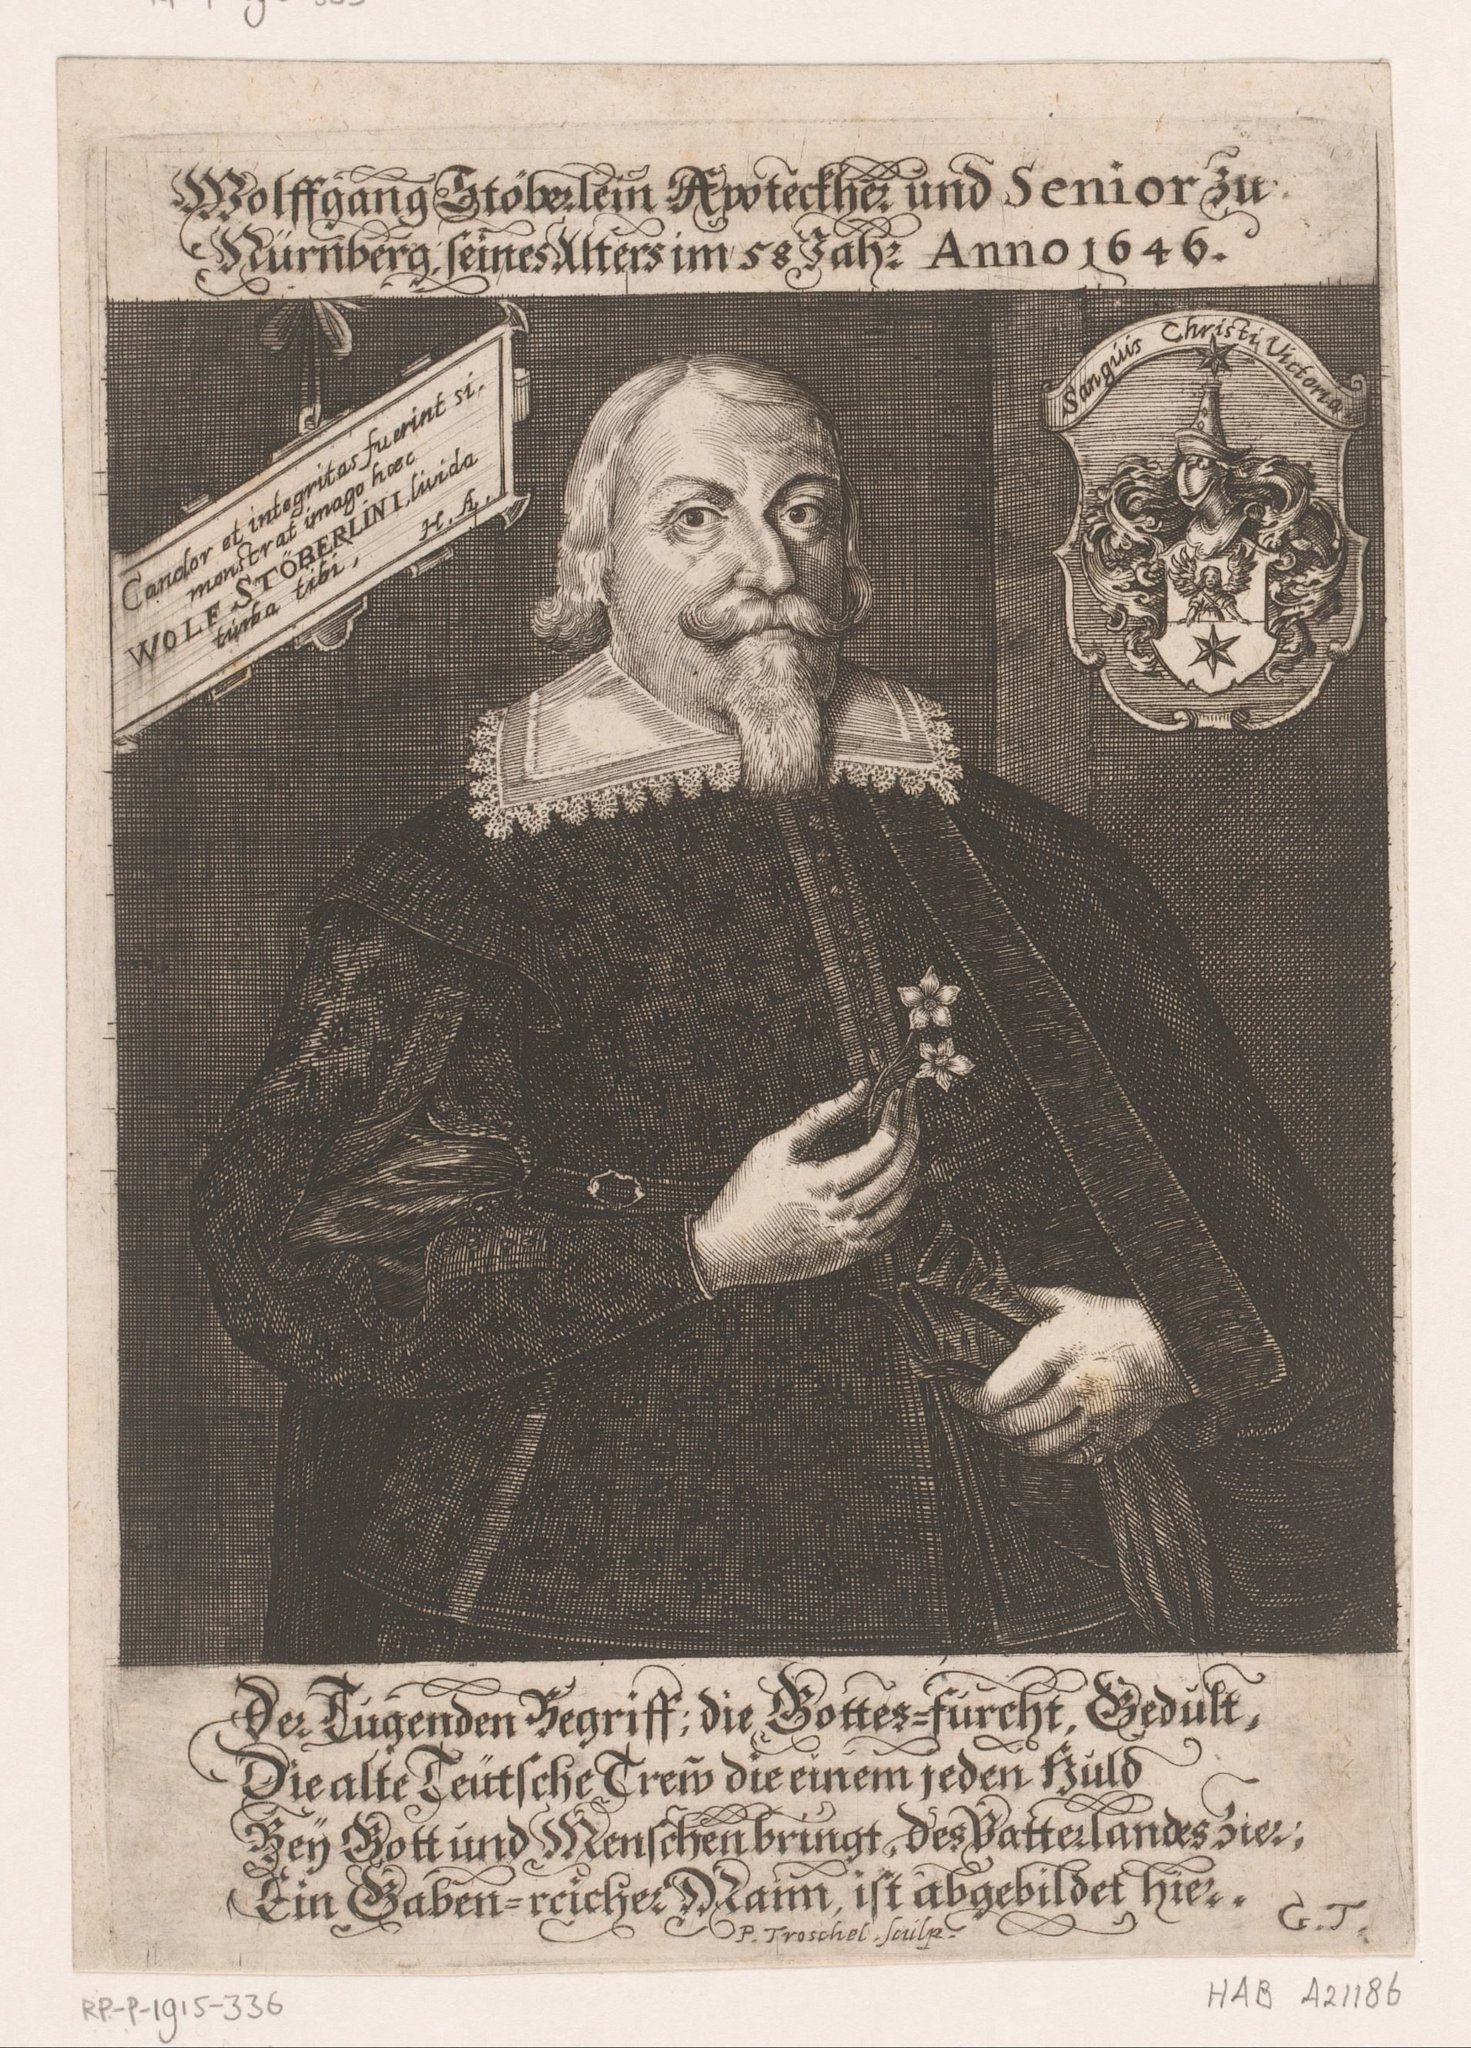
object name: print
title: Portret van Wolfgang Stöberlein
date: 1646-1670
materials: paper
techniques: engraving, intaglio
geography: germany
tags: flowers, gloves, mittens, etc., historical persons, armorial bearing, heraldry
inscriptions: collector's mark: Lugt 2228